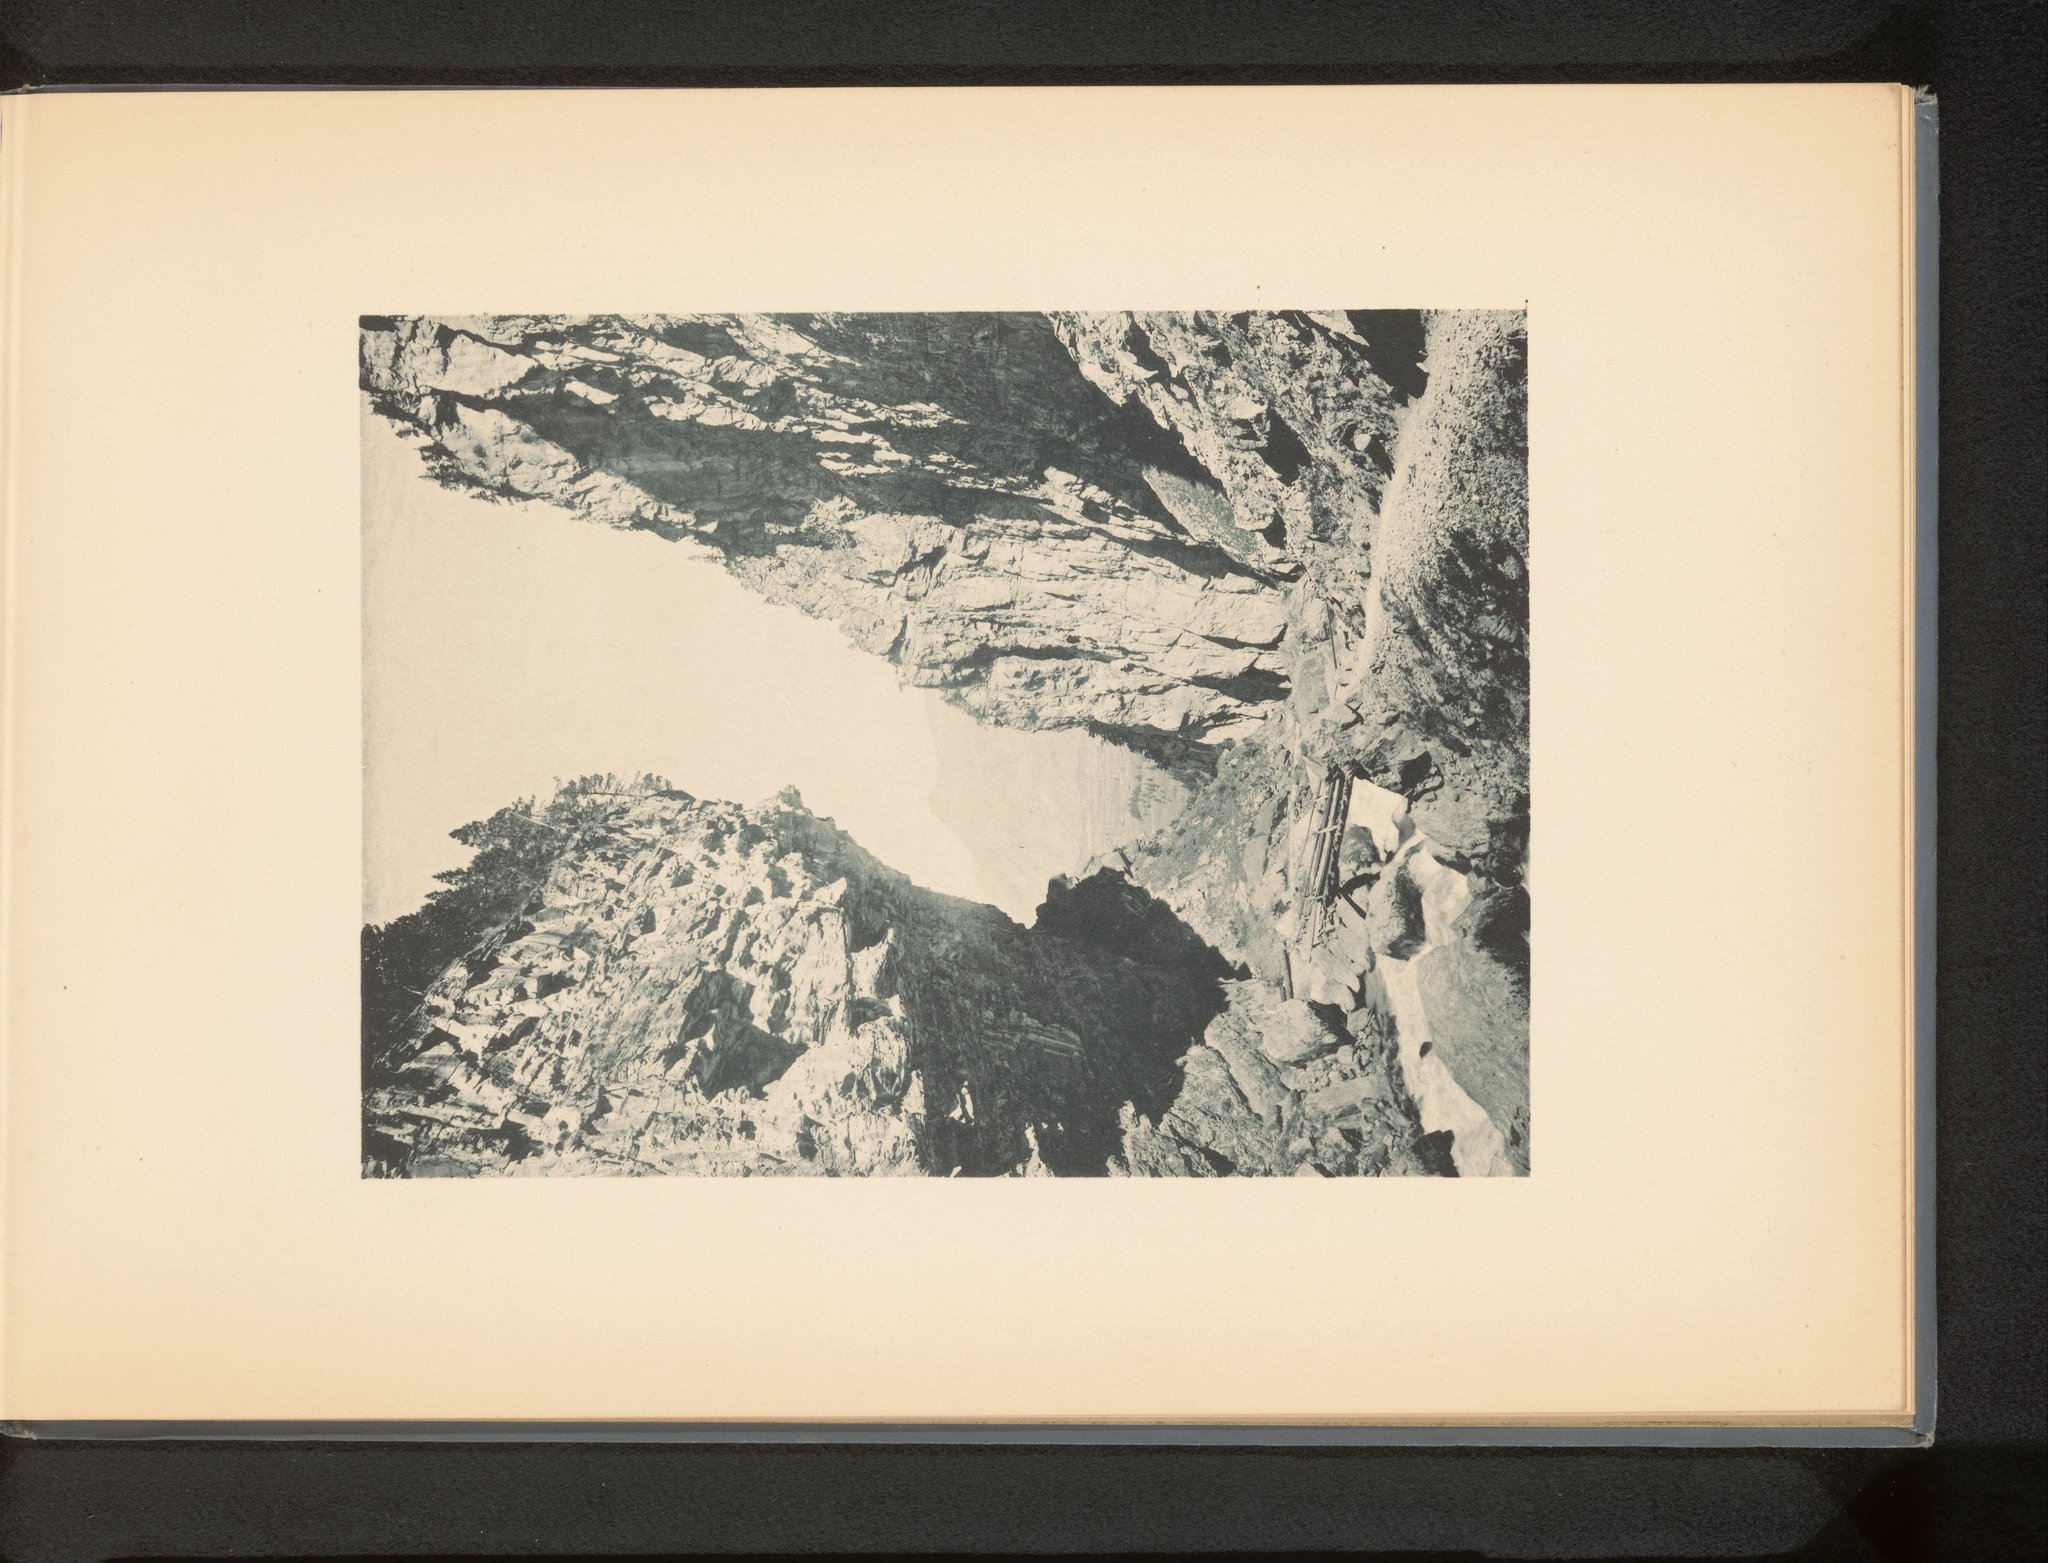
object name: photomechanical print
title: Gezicht op een rotswand in de vallei van Gastern in Kandersteg, Zwitserland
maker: Anonymous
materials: paper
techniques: photograph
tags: landscapes, rock-formations, mountains